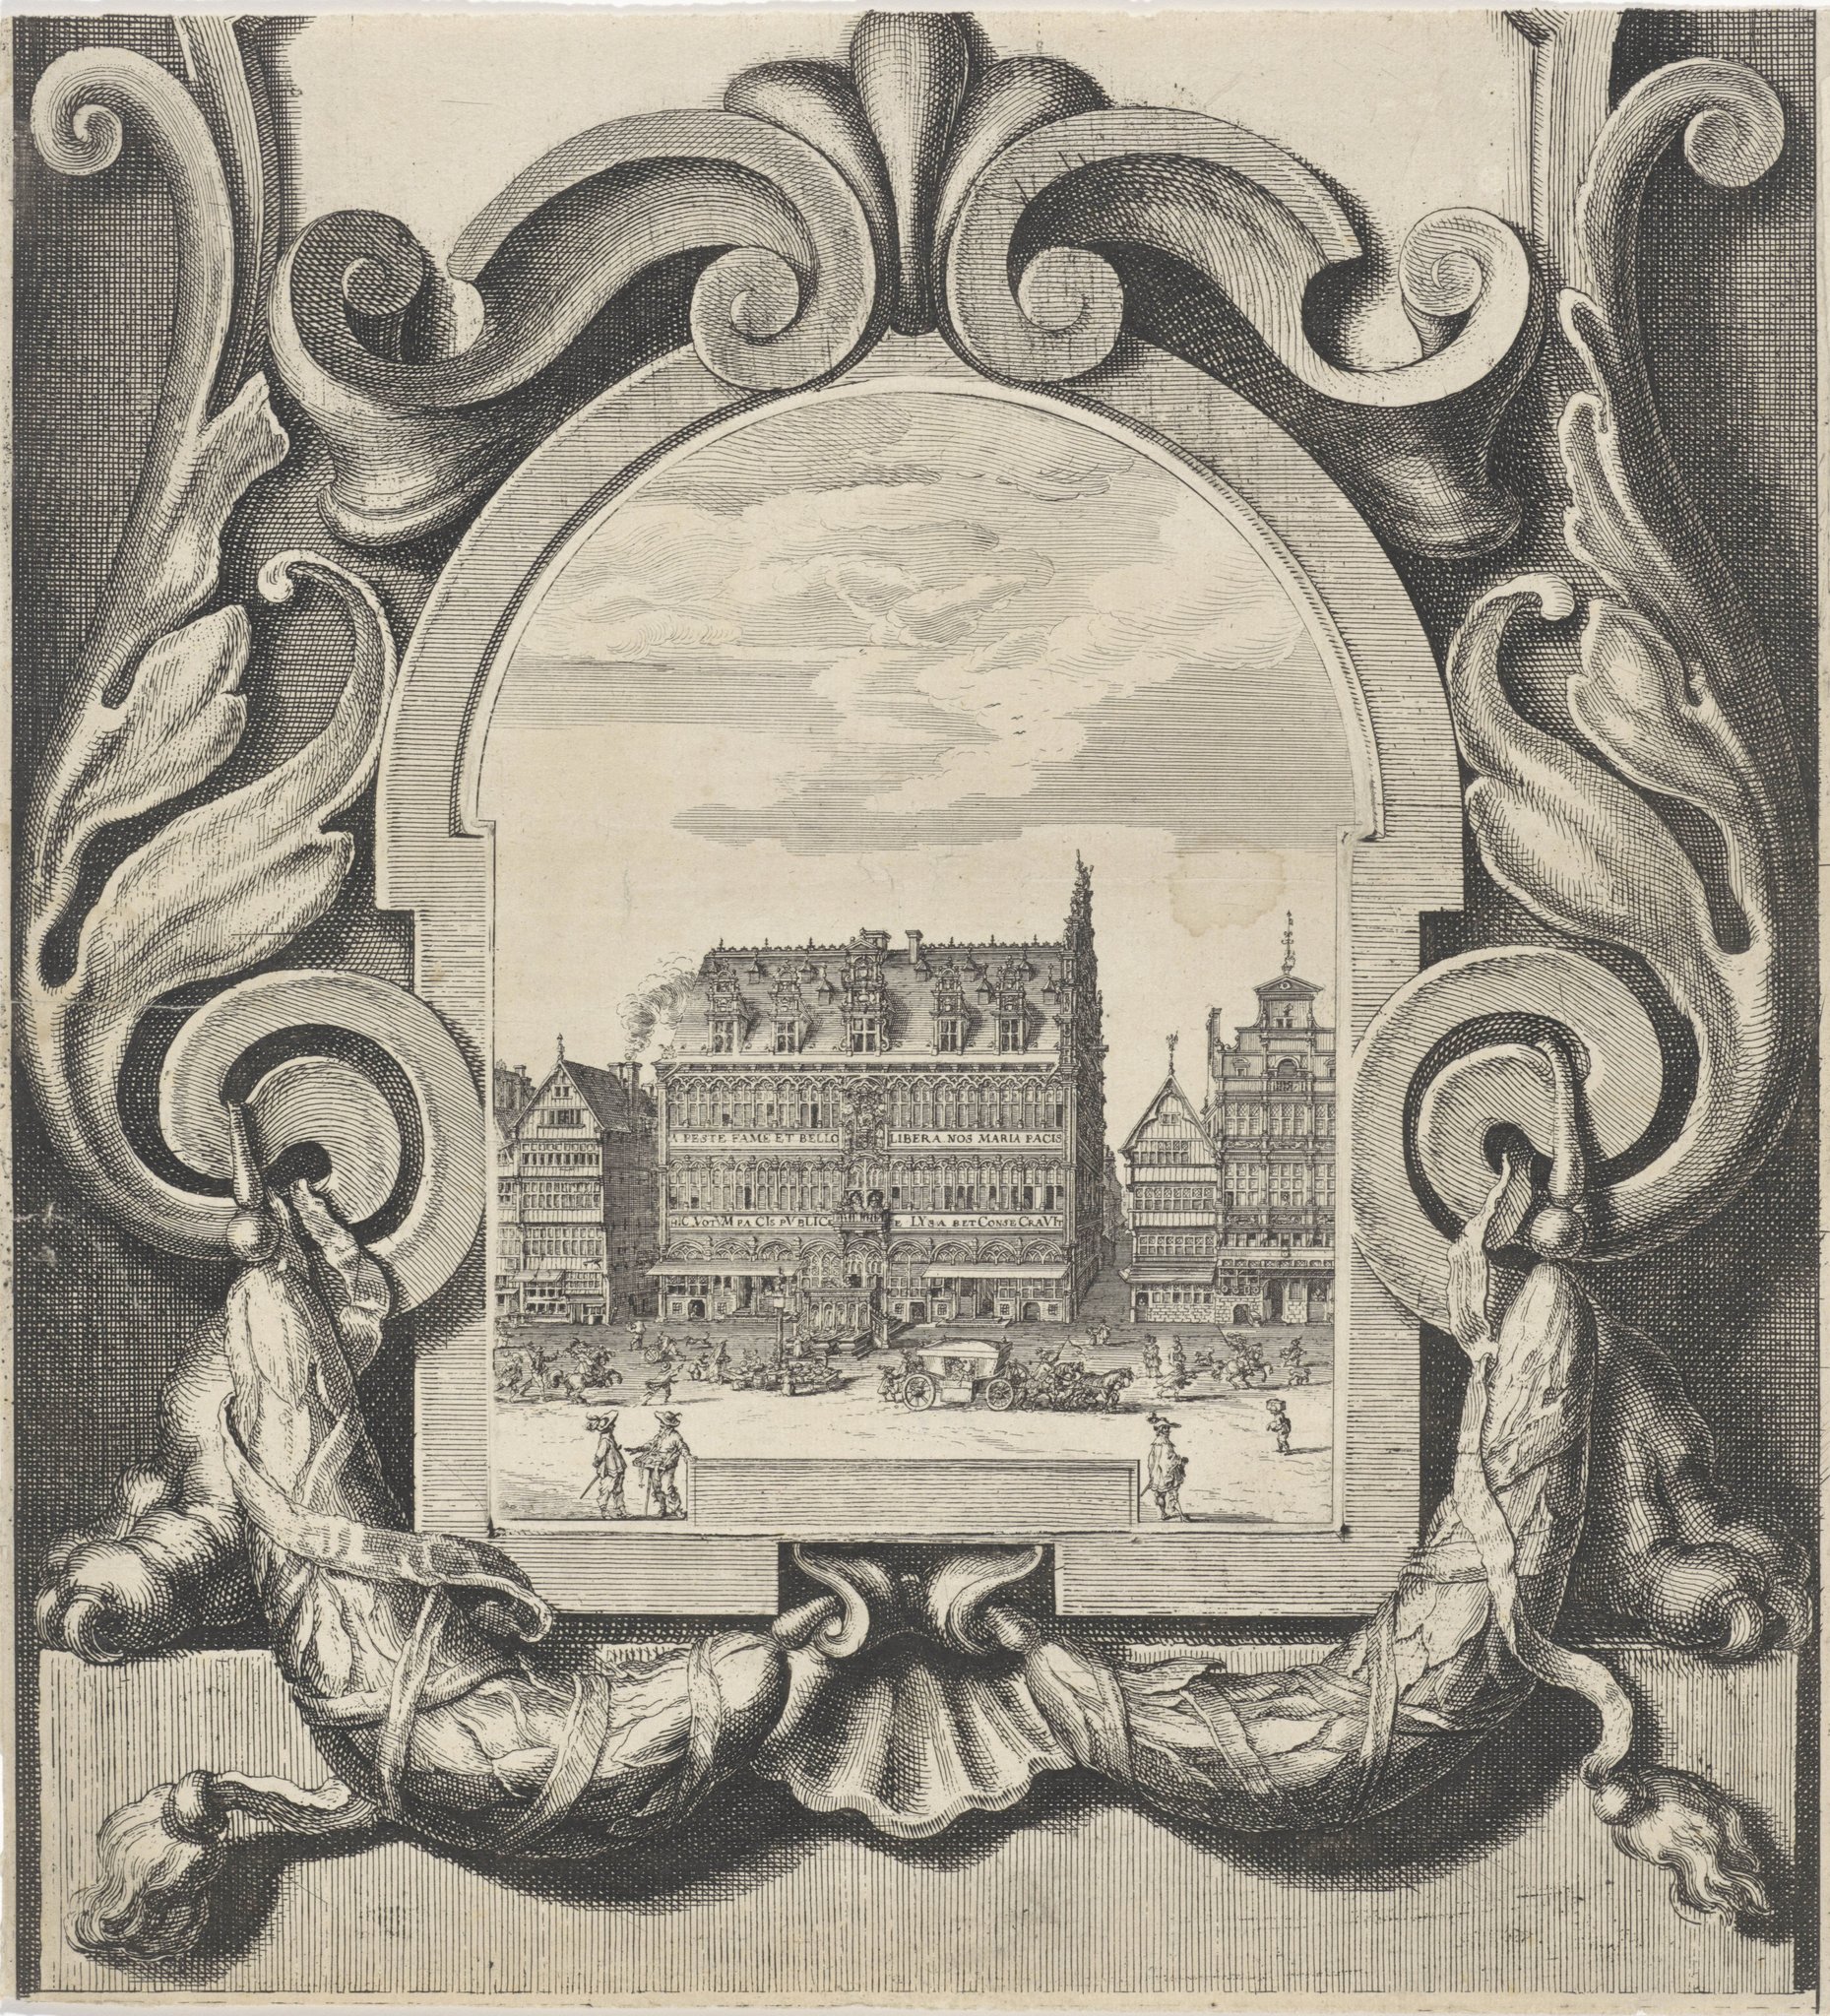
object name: print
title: Gezicht op het Broodhuis te Brussel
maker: abraham dircksz. santvoort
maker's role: print maker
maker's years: 1614-1669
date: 1640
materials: paper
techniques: etching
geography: brussels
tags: ornament ~ festoon, garland, city-view, and landscape with man-made constructions (+ city(-scape) with figures, staffage)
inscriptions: collector's mark: Lugt 2228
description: Gezicht op het Broodhuis te Brussel vanaf de Grote Markt. Links en rechts nog enkele gebouwen. Over het marktplein rijden een koets en enkele ruiters. De voorstelling heeft een ornamentele omlijsting met een guirlande.